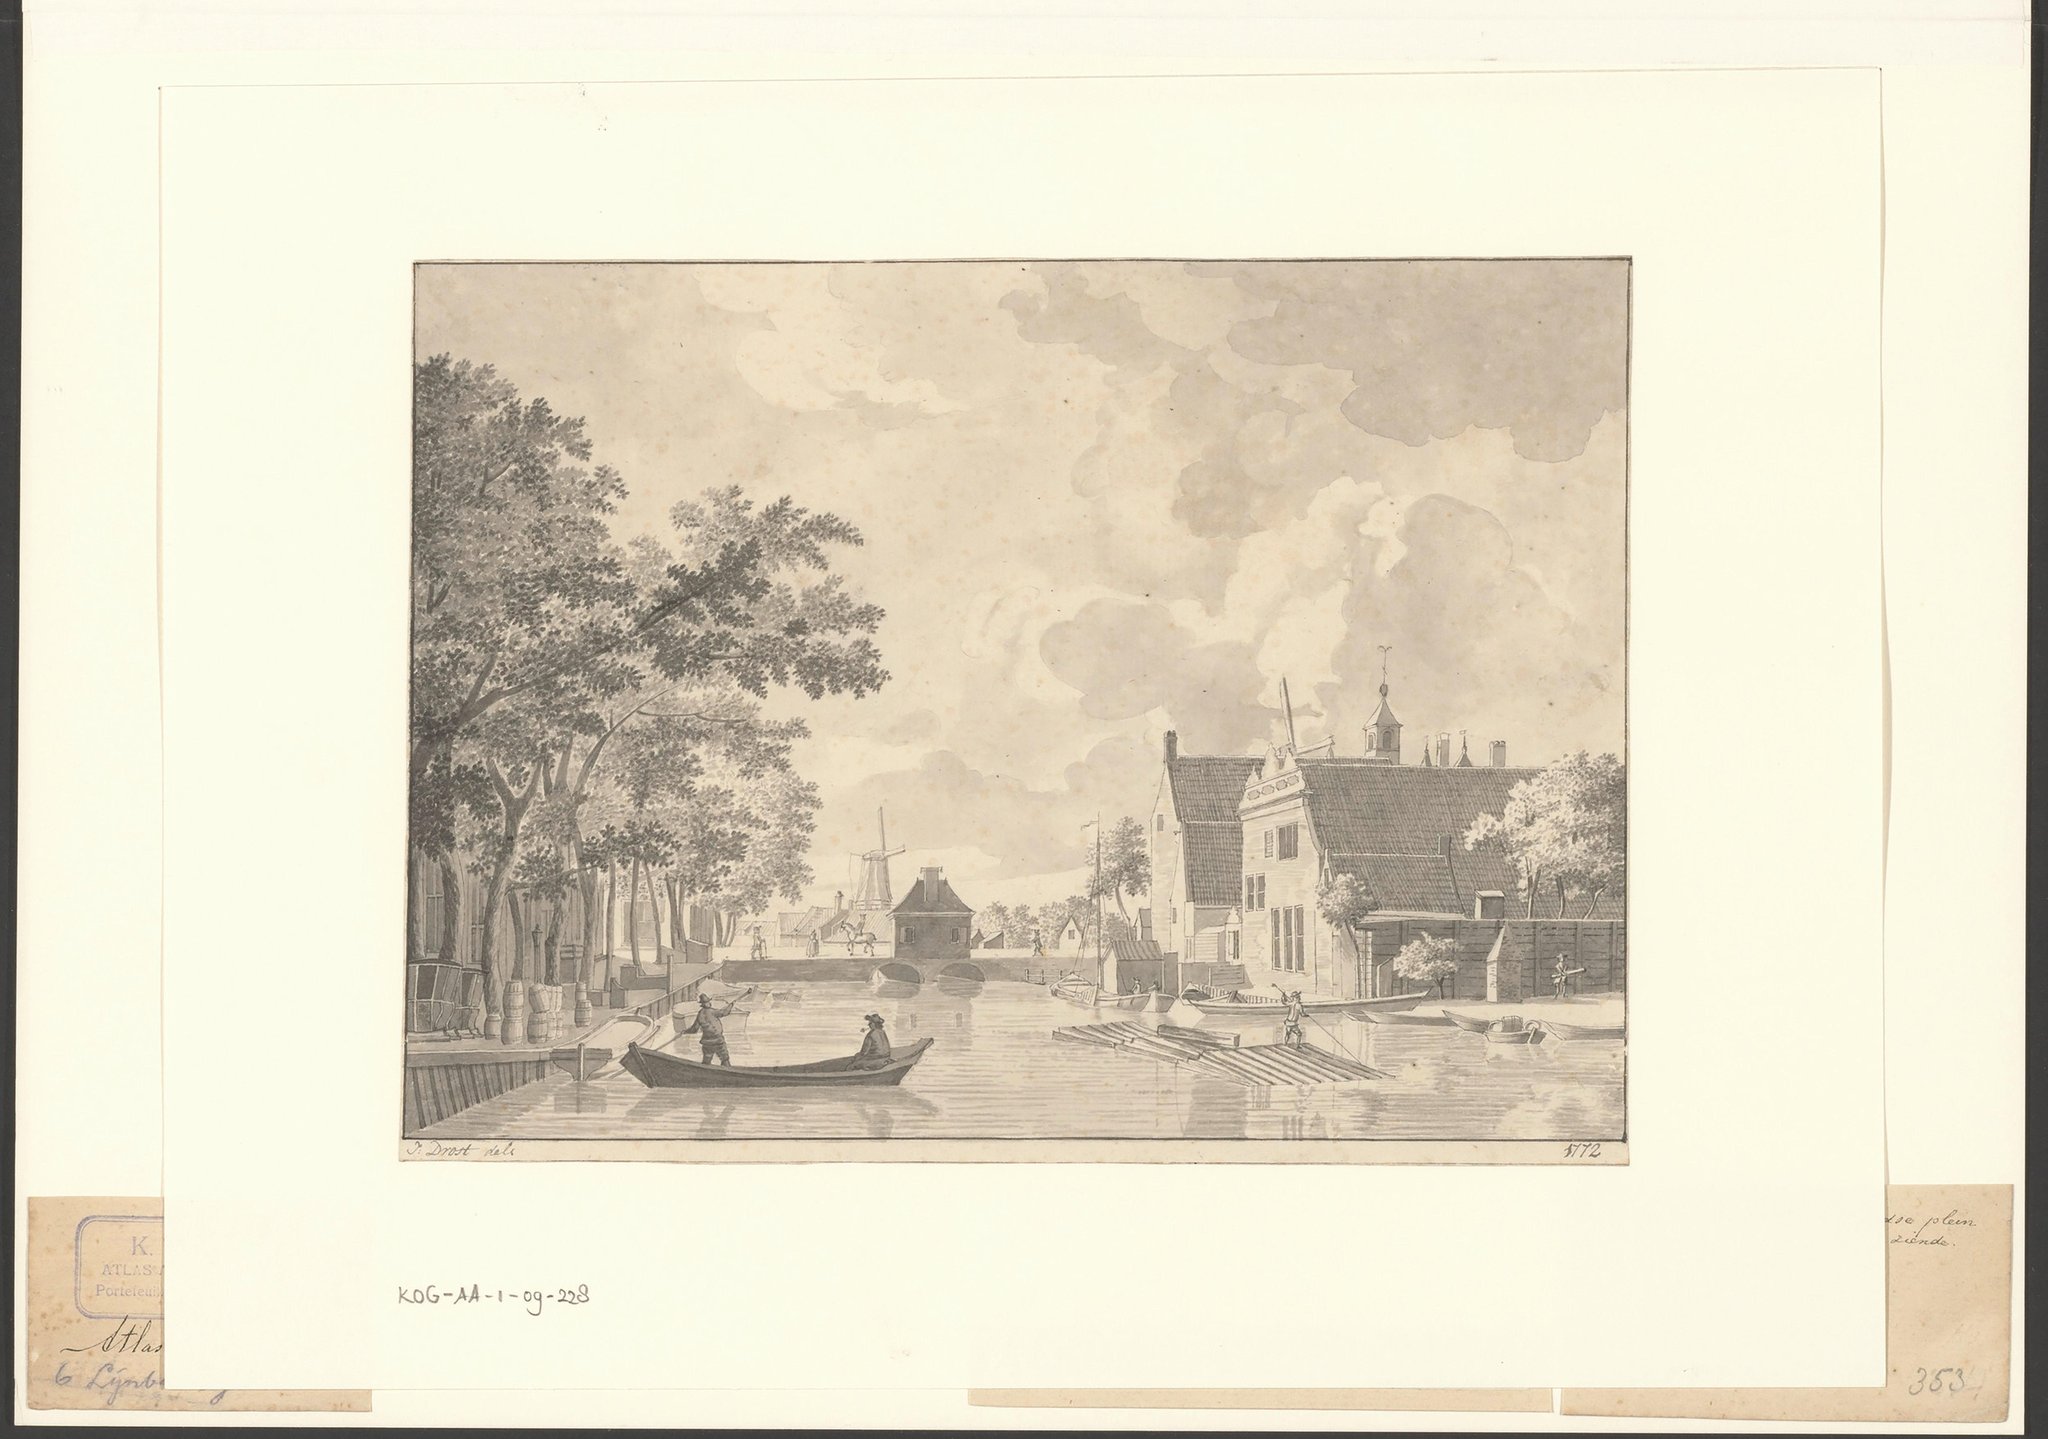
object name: drawing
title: Gezicht over de Lijnbaansgracht, gezien naar molen De Roomolen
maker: j. drost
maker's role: draughtsman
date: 1772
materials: ink, paper, pencil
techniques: brush, pen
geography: amsterdam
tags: city-view in general; 'veduta', canal, street, boat propelled by man or animal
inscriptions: signature and date: ‘J: Drost deli / 1772’, stamp: ‘HGd[...]’, inscription: ‘Gesigt van 't Rijschool / op t Leijdse Plijn zien de.’, inscription: ‘Atlas D.C. Meijer (...) ziende. / a 1772.’, inscription: ‘Port. 9-228’, collector's mark: ‘9’ Lugt 1641b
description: Onderwerpsrubriek binnen de Atlas Amsterdam: 2e Laurierdwarsstraat (Vuile Weespad), Leidschegracht, Leidschekade, Leidscheplein, Leidschestraat, v. Lennepkade, Lijnbaansgracht, Lauriergracht, Leliedwarsstraat, Leliegracht, Lindengracht, Lombardsteeg, Looiersgracht, Looiersstraat (Nieuwe), Leidekkerssteeg.